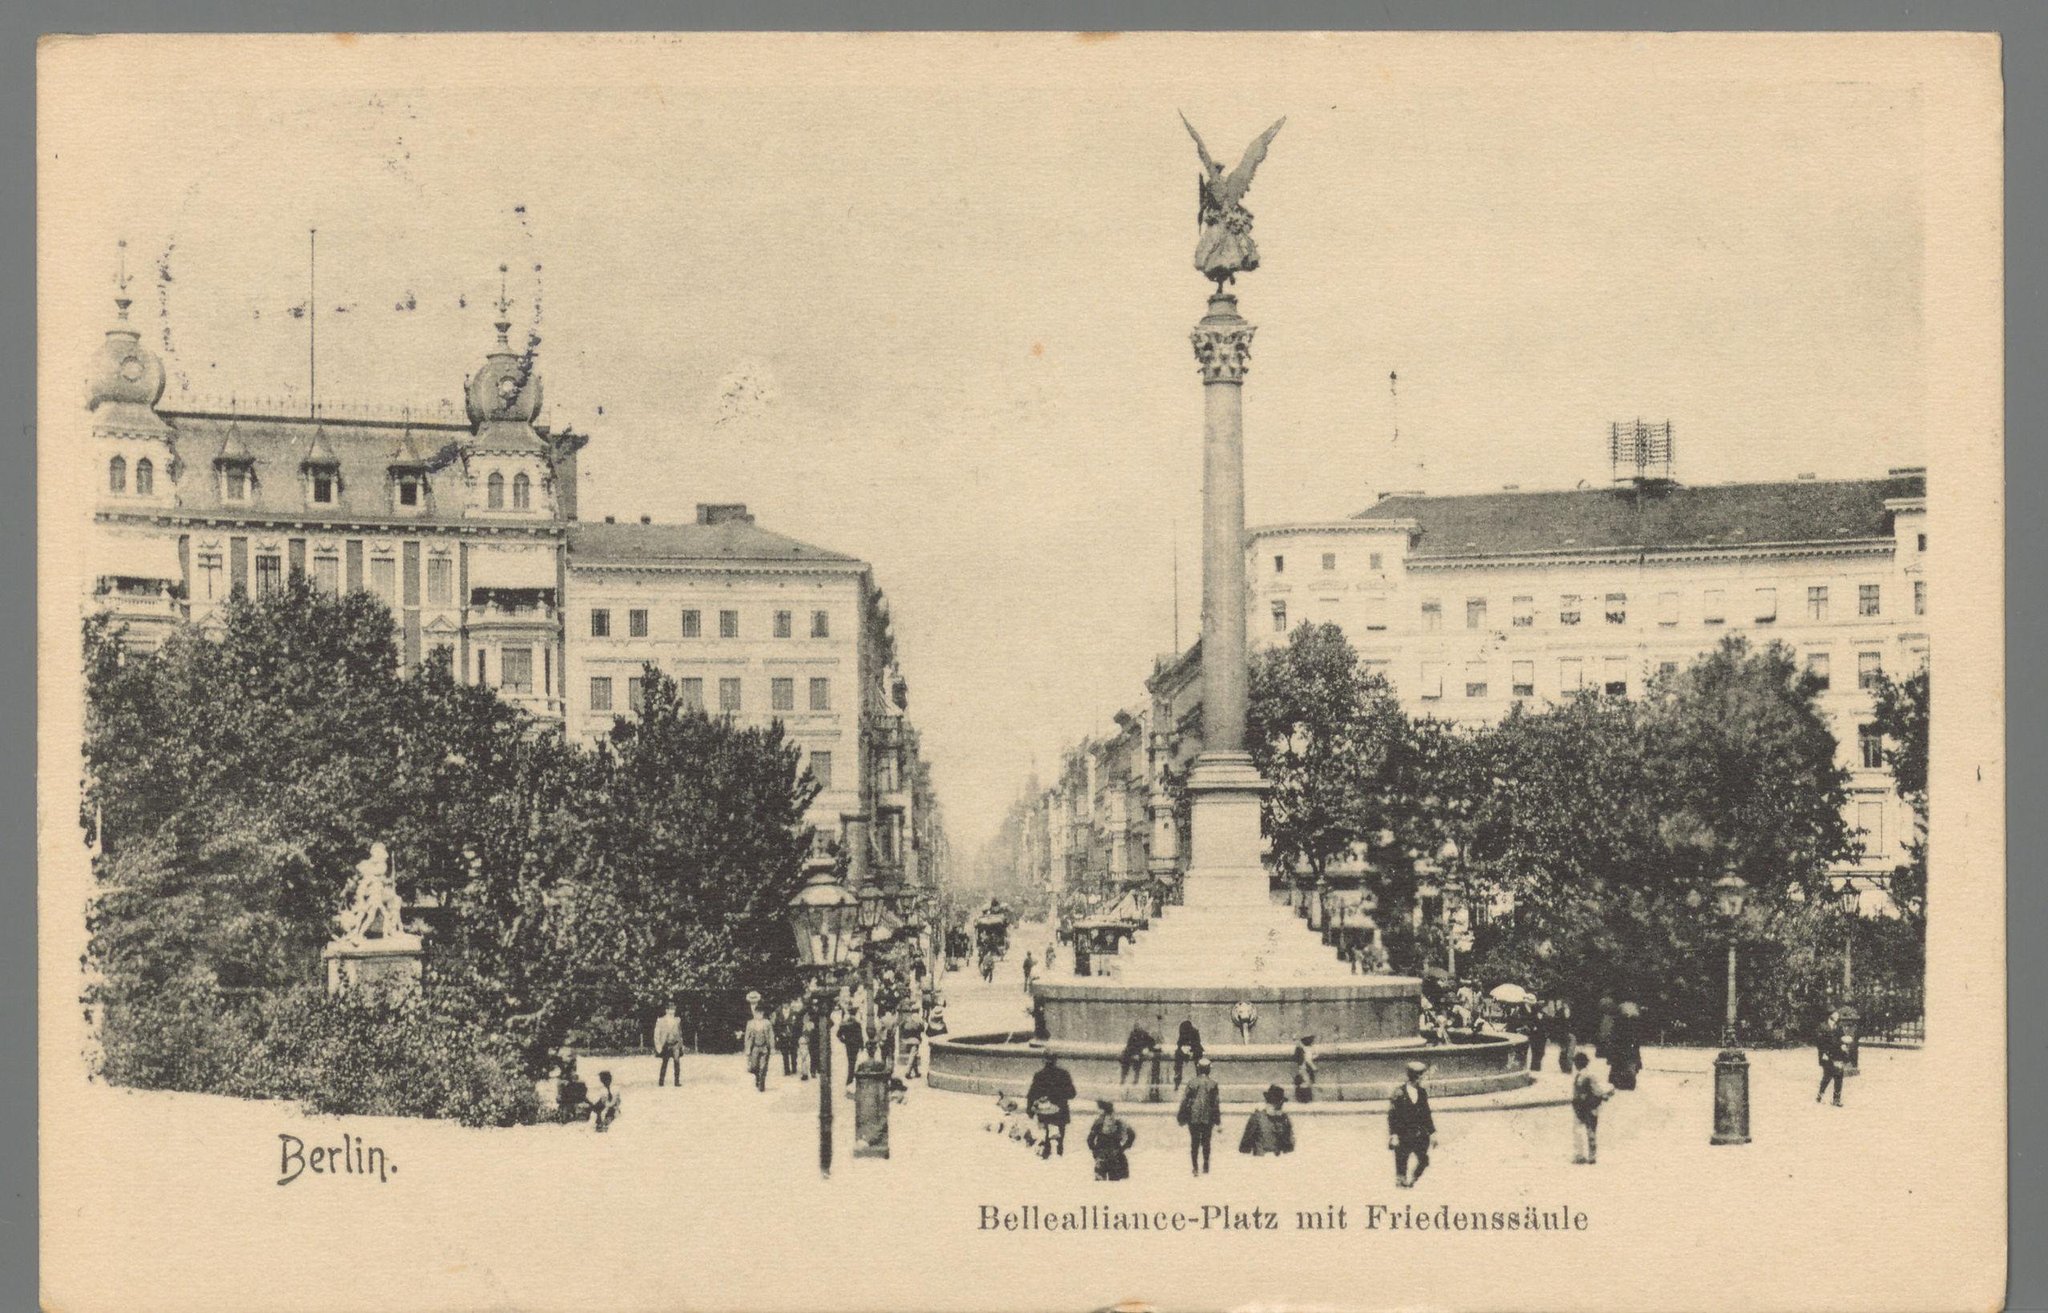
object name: ansichtkaart, prentbriefkaart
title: Berlin. Bellealliance-Platz mit Friedenssäule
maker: Anonymous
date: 1885-1903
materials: cardboard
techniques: photograph, writing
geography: berlin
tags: square, place, circus, etc., monument, statue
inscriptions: postage stamp